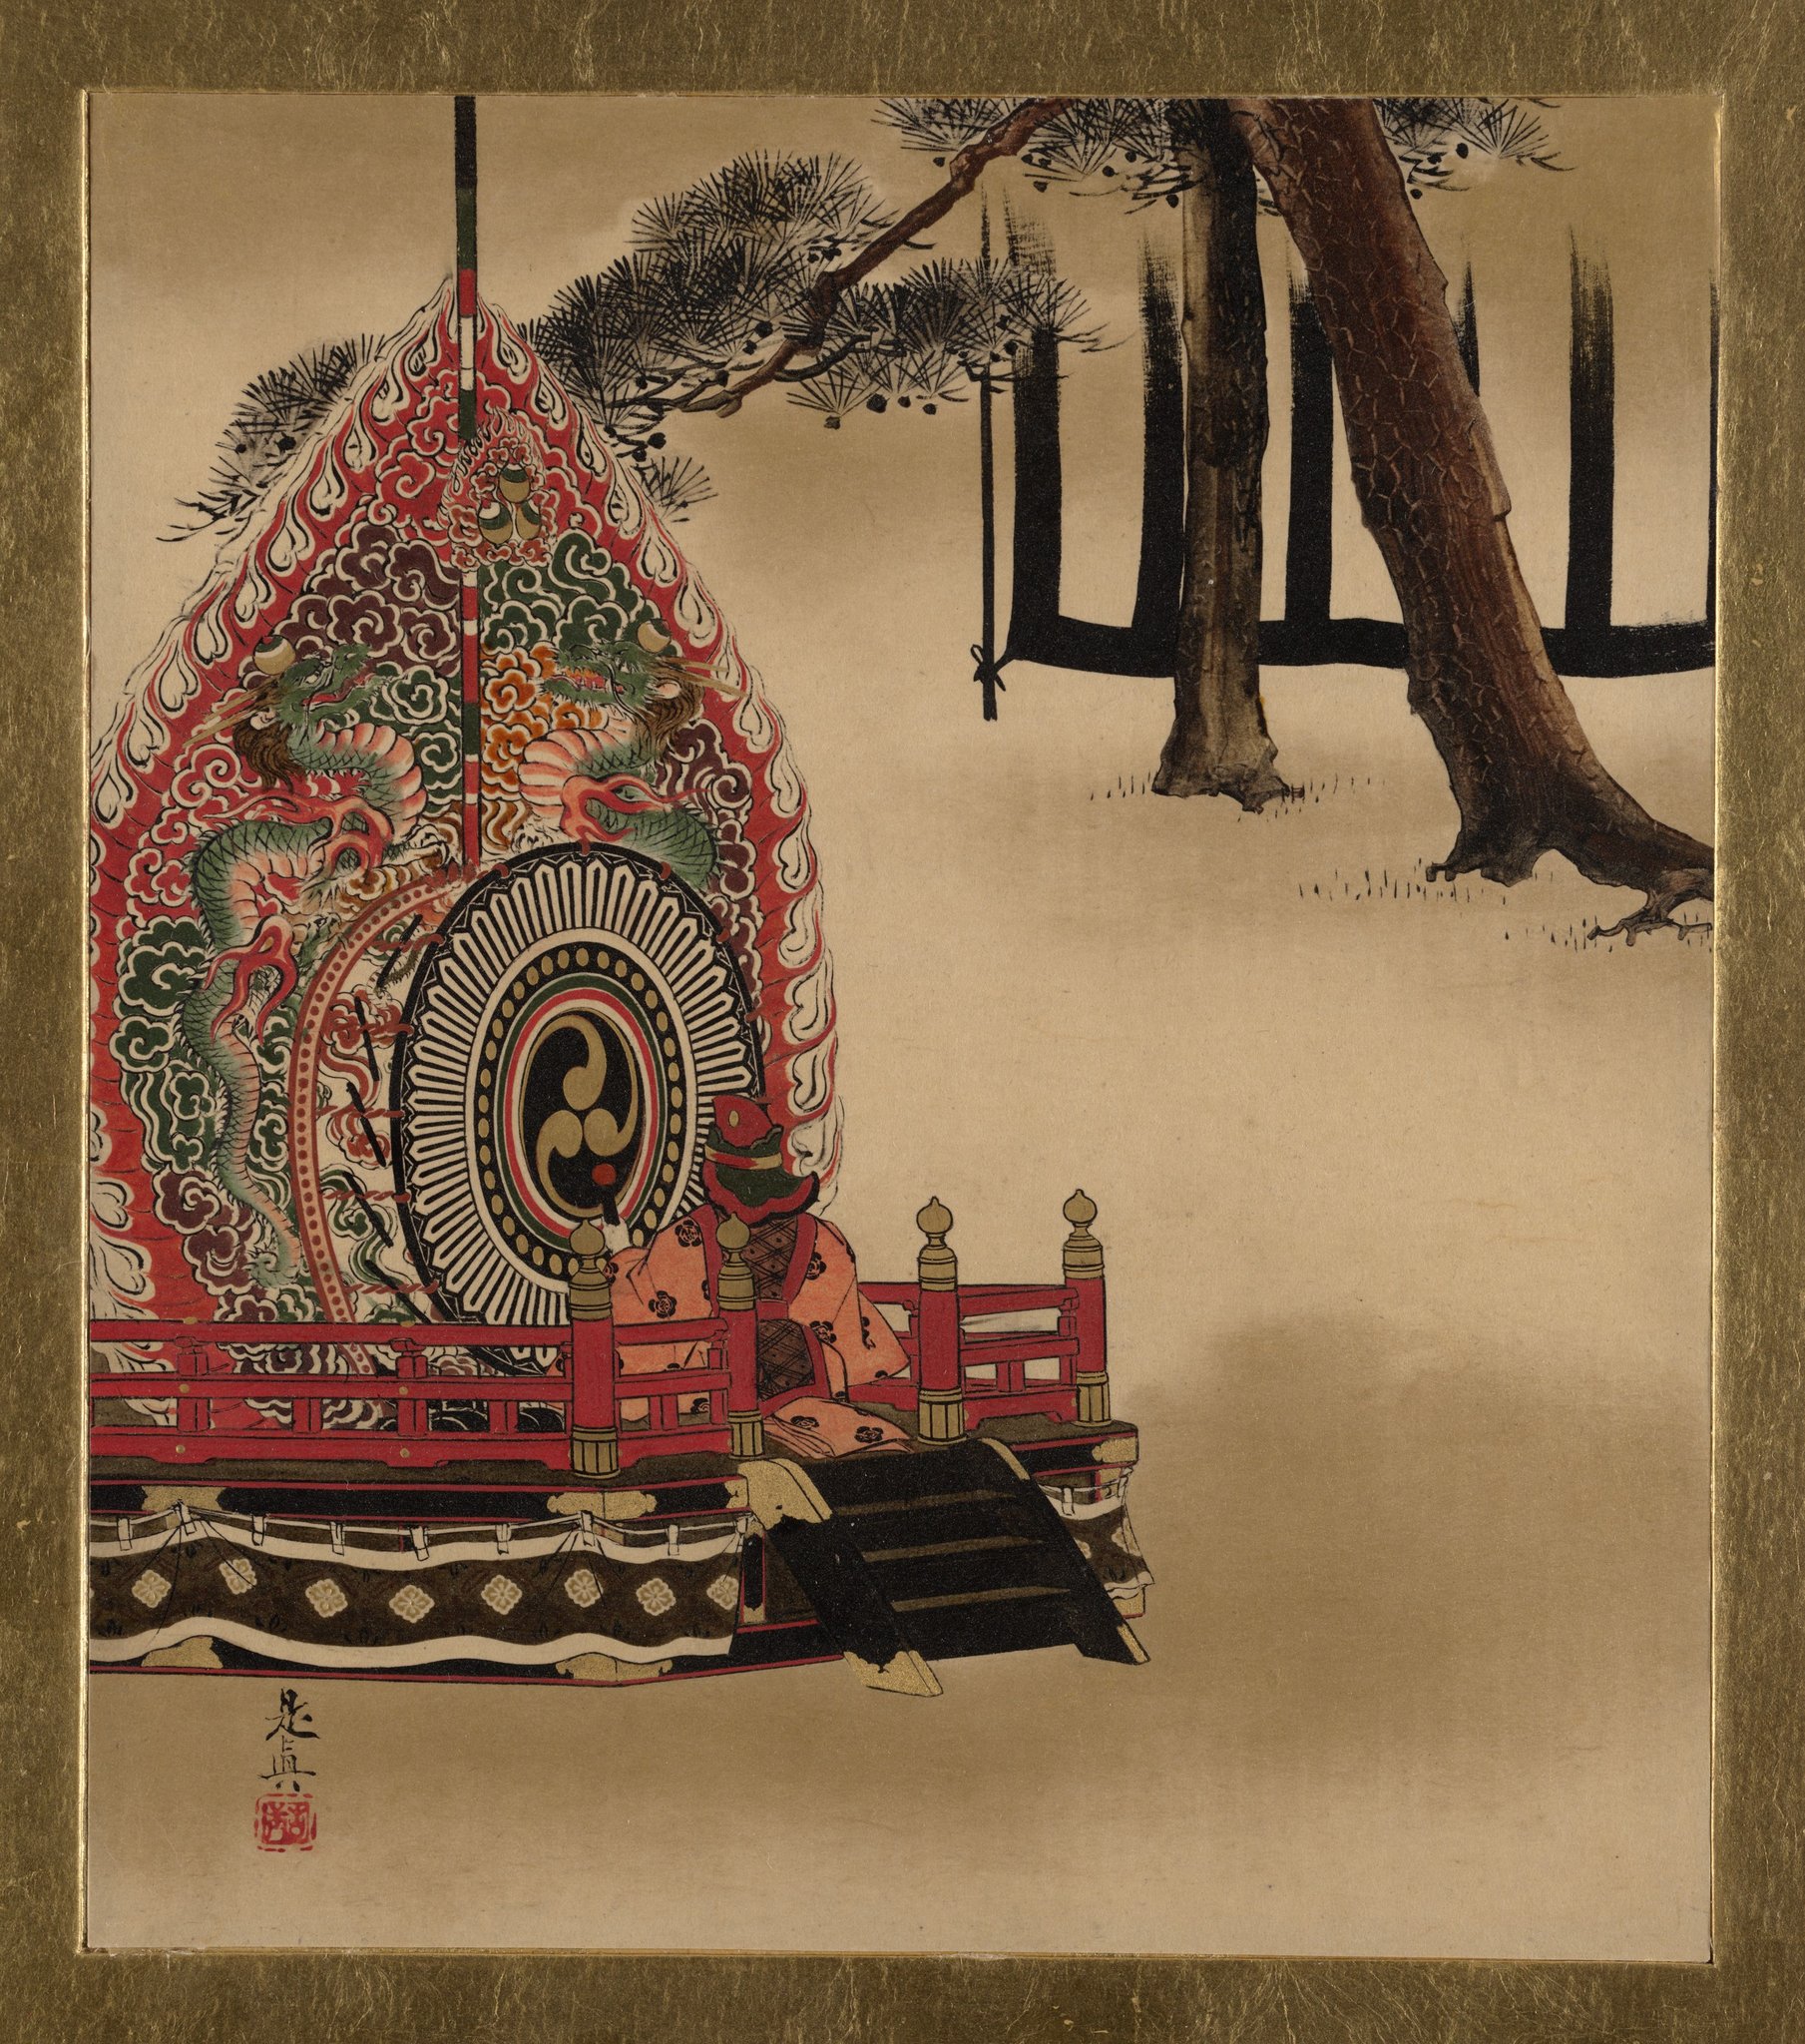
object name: painting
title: Lacquer Paintings of Various Subjects: Drum for Gagaku Dance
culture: japanese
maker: shibata zeshin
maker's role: artist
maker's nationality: japanese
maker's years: 1807-1891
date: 1882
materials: lacquer, paper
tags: drums,dragons,trees